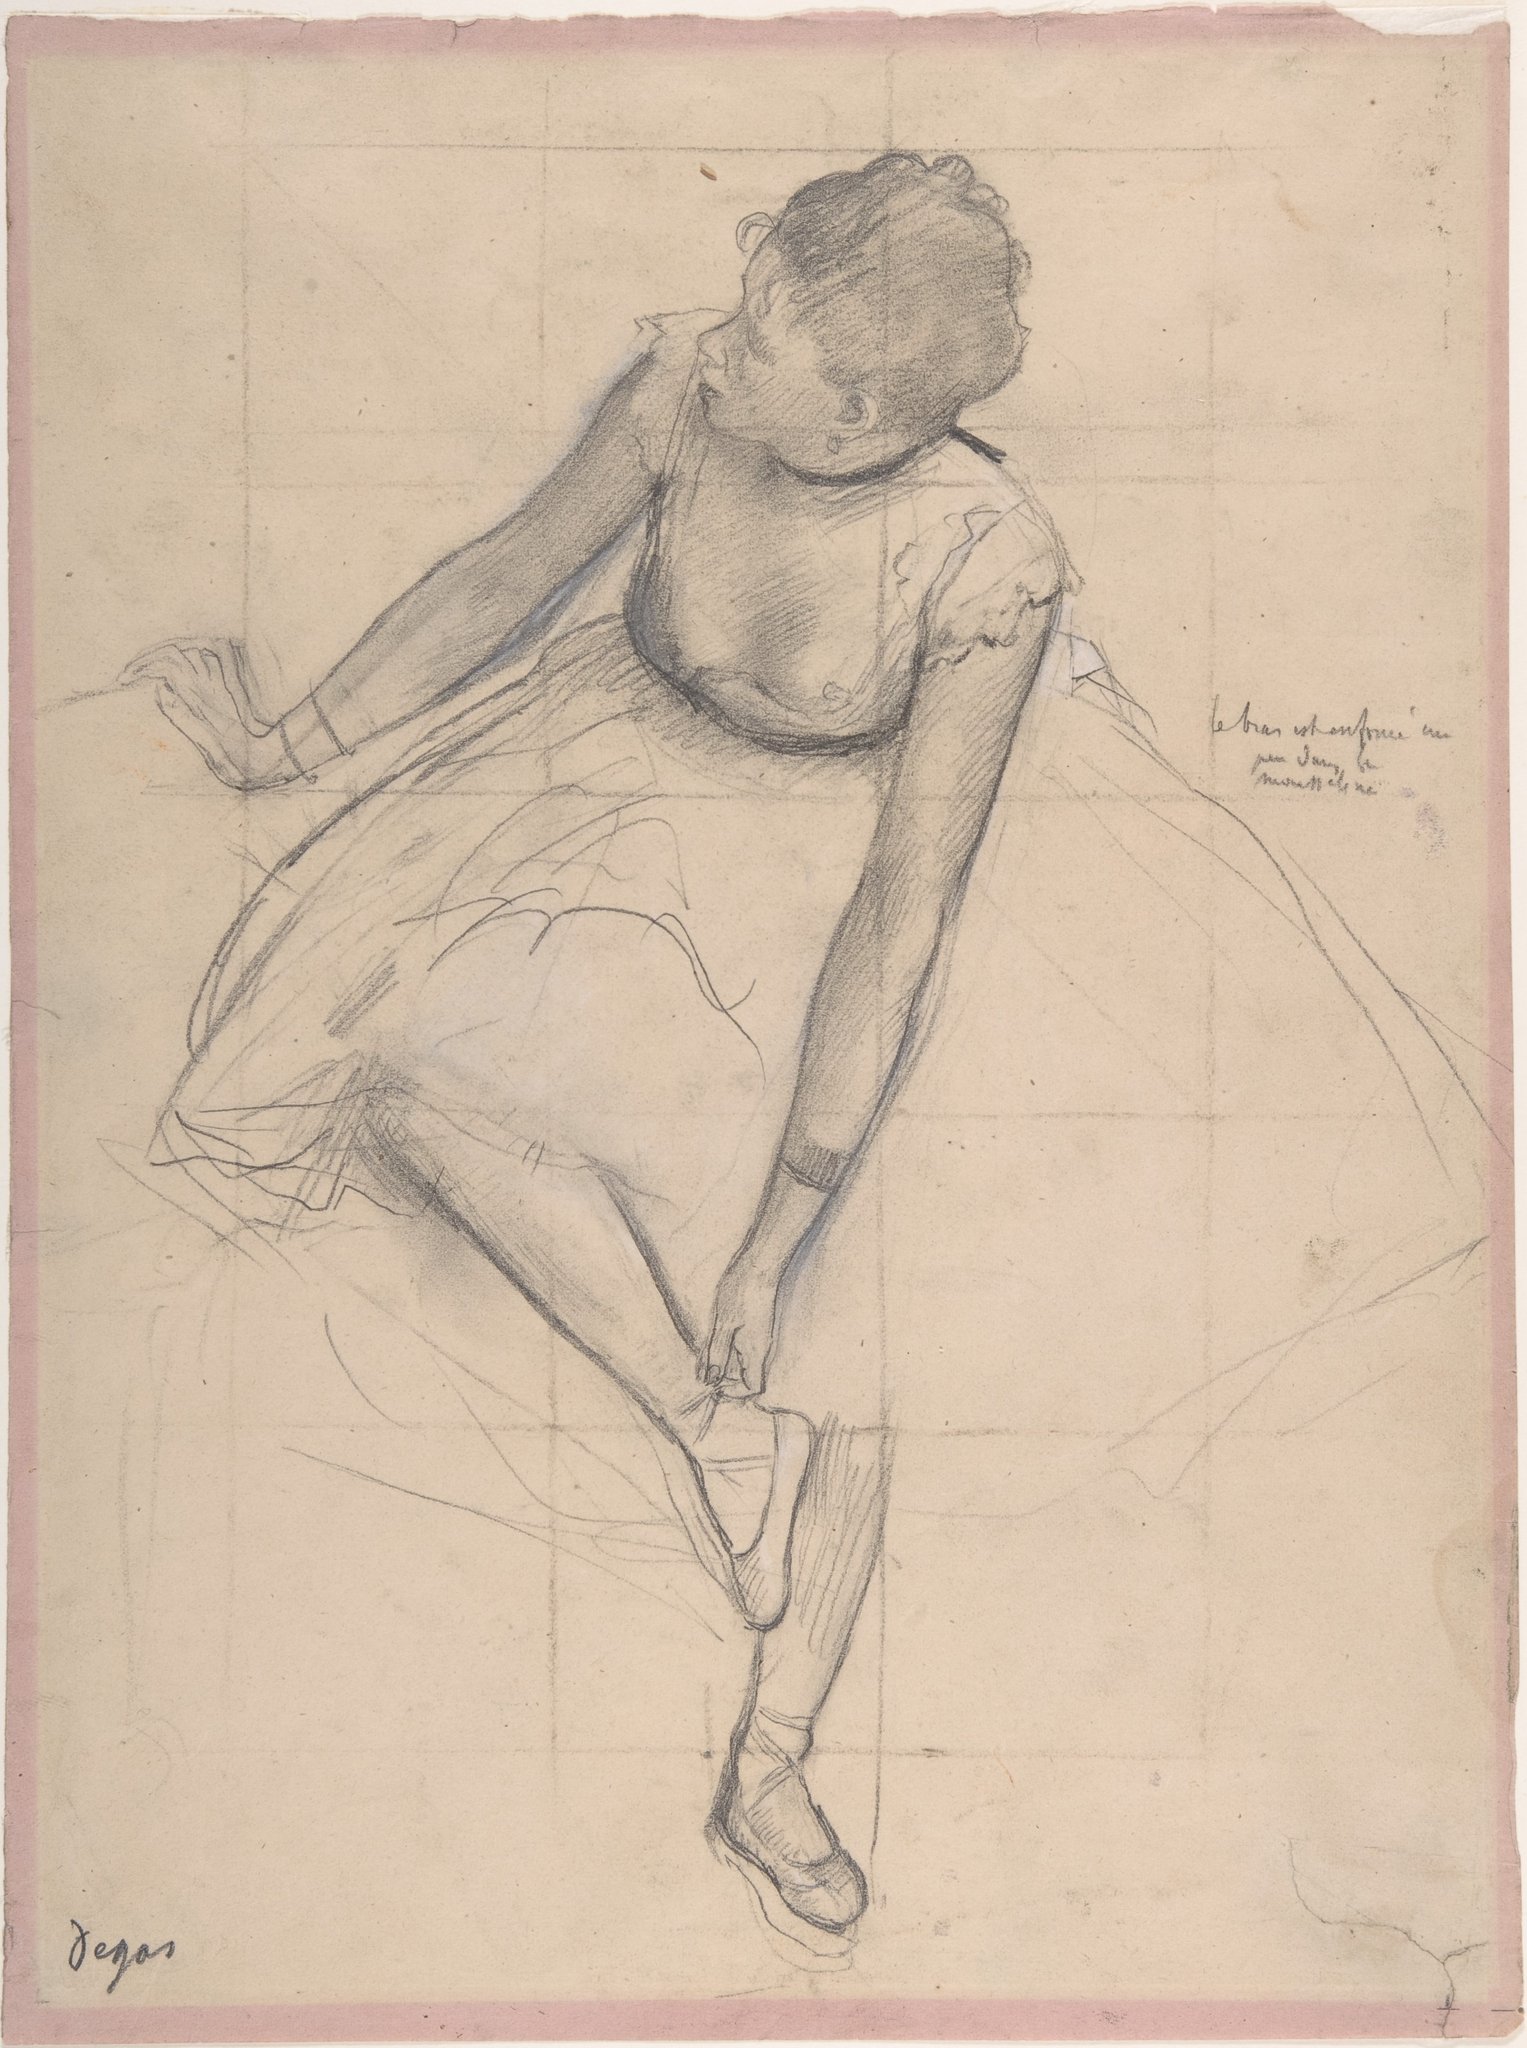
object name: drawing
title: Dancer Adjusting Her Slipper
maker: edgar degas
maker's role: artist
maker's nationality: french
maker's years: 1834-1917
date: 1873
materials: chalk, graphite, paper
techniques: heightening, drawing, transfer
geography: france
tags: women,dancers,ballet